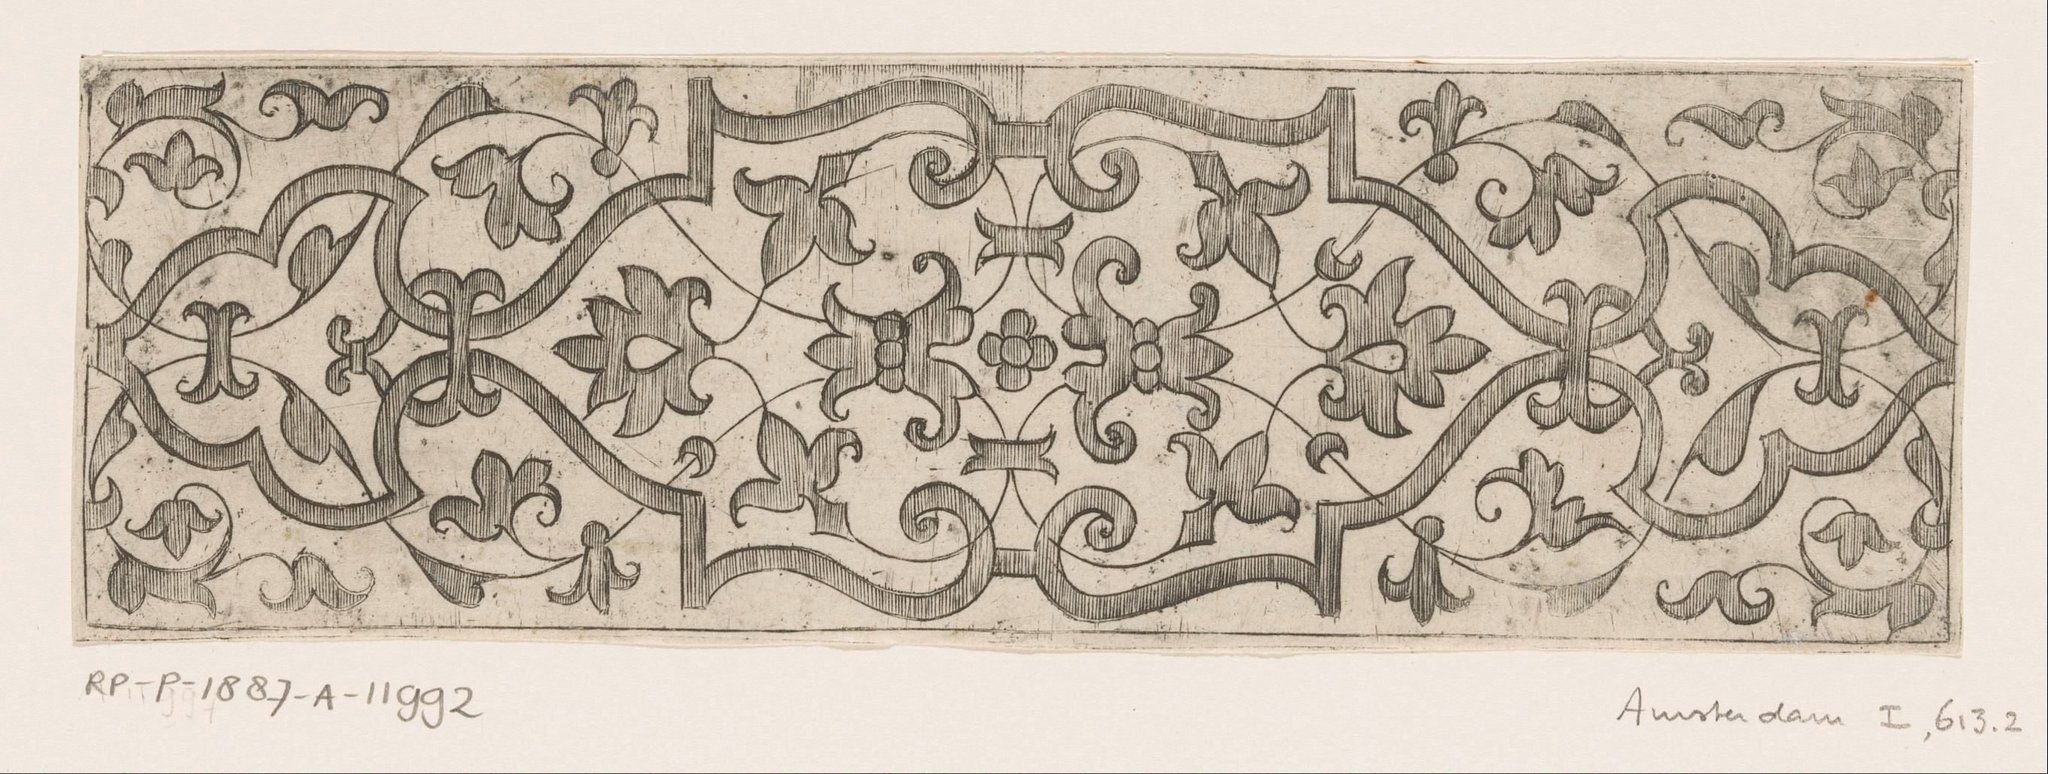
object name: print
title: Ornamentrand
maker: monogrammist f (italië)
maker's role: print maker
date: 1500-1599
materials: paper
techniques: engraving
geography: italy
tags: foliage ~ ornament - aa - stylized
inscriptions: collector's mark: Lugt 2228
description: Fries met moresken in een gesp-achtige vorm. Daartussen bevinden zich arabesken.